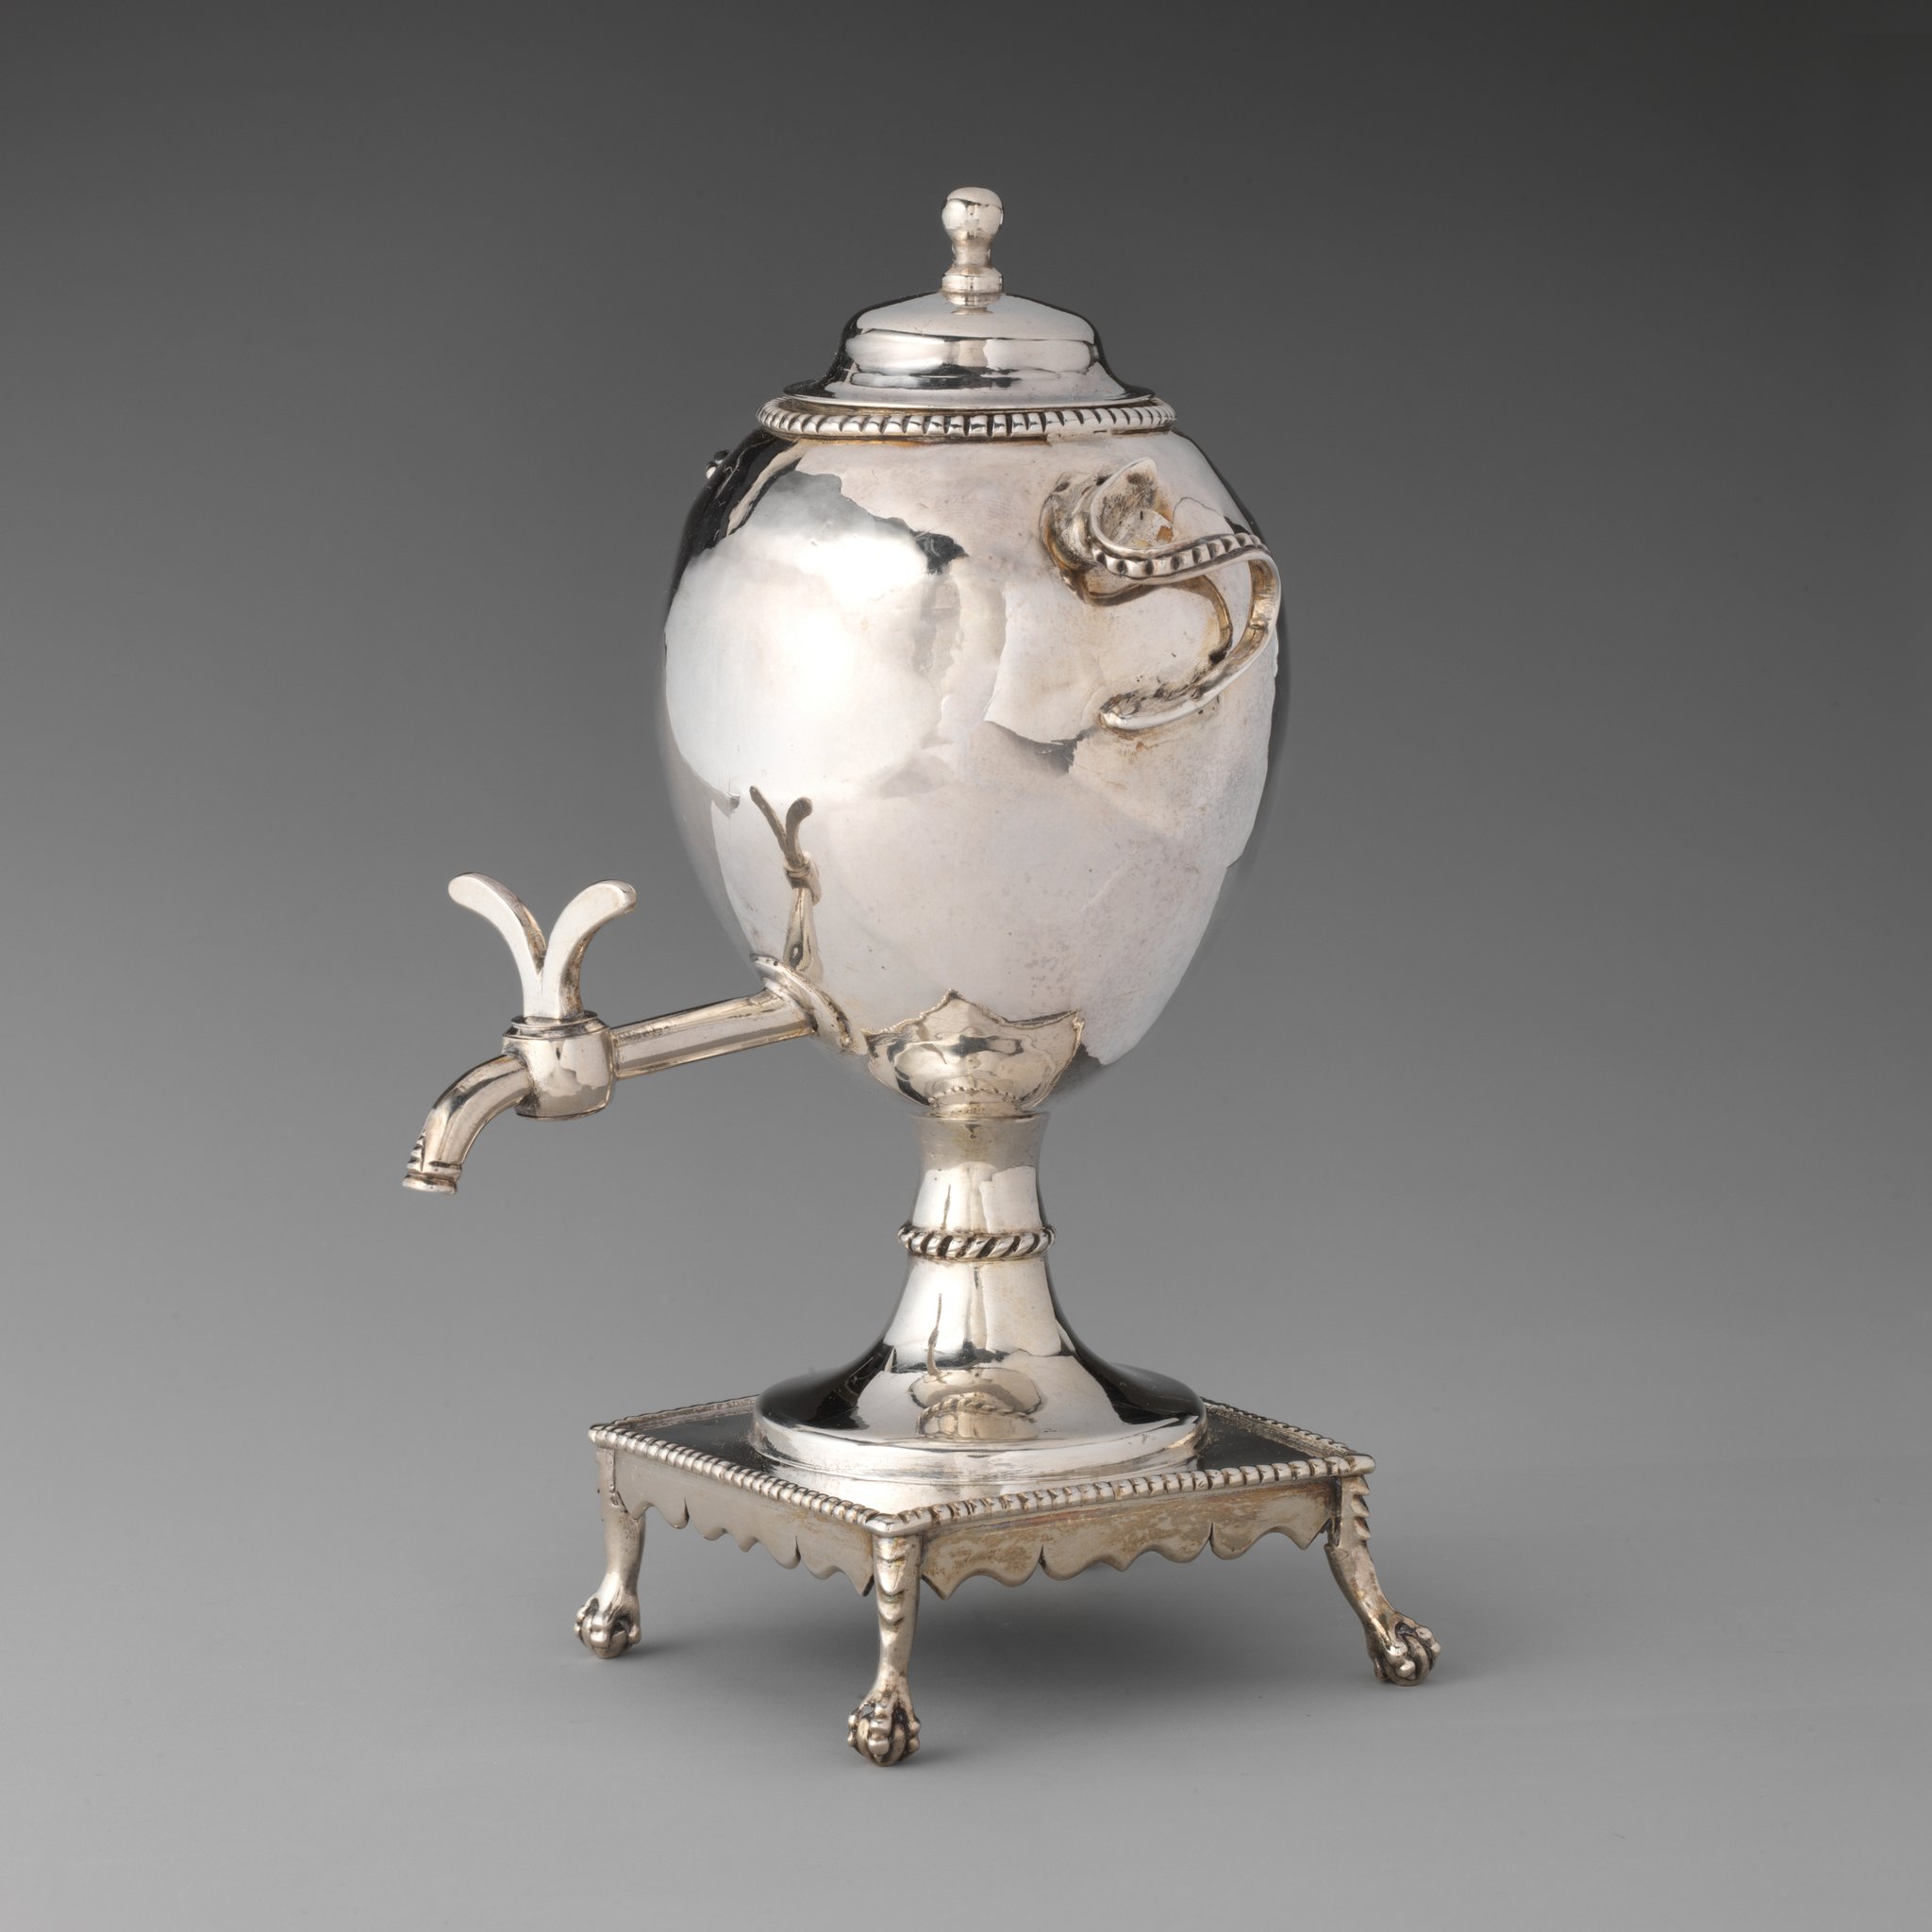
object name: urn with cover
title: Miniature urn with cover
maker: a. l. & w. l.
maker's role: maker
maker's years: 1725-1825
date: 1780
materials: silver